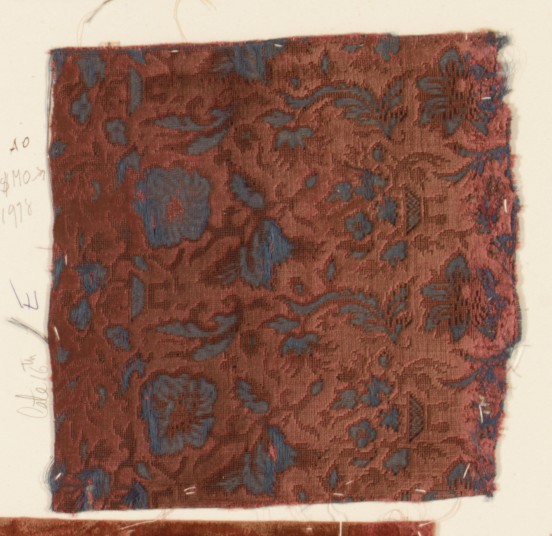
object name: fragment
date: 1567-1600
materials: silk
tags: flowers,leaves